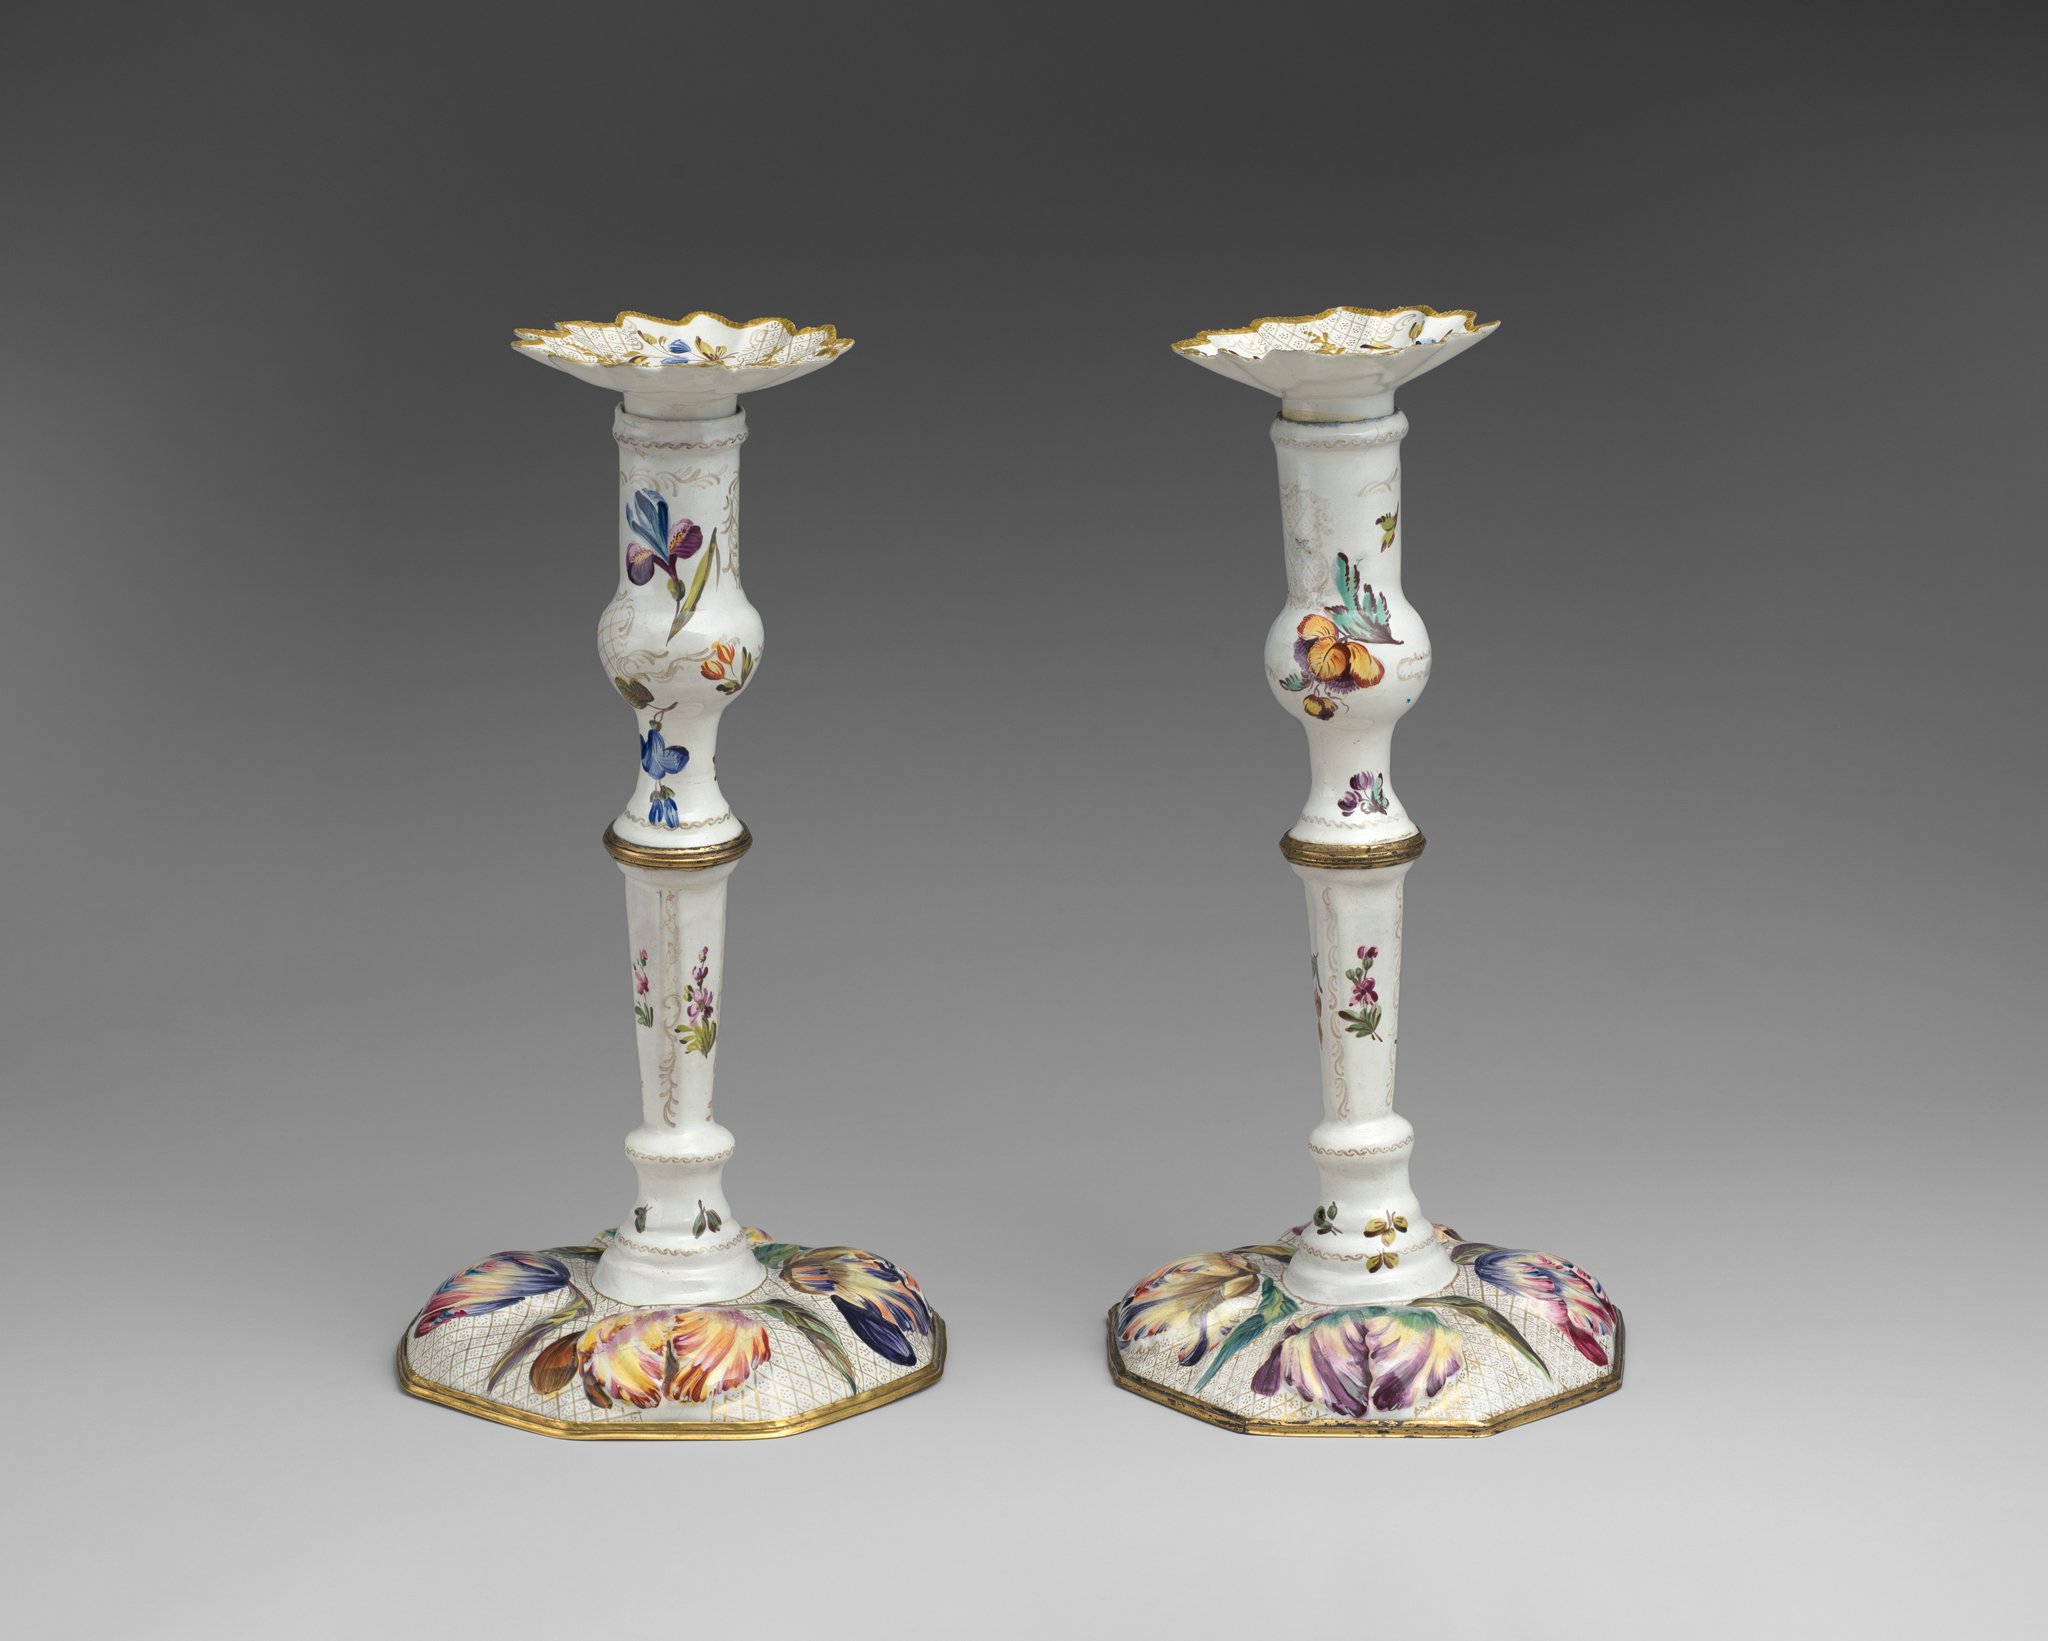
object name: candlestick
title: Pair of candlesticks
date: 1770-1780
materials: copper, enamel